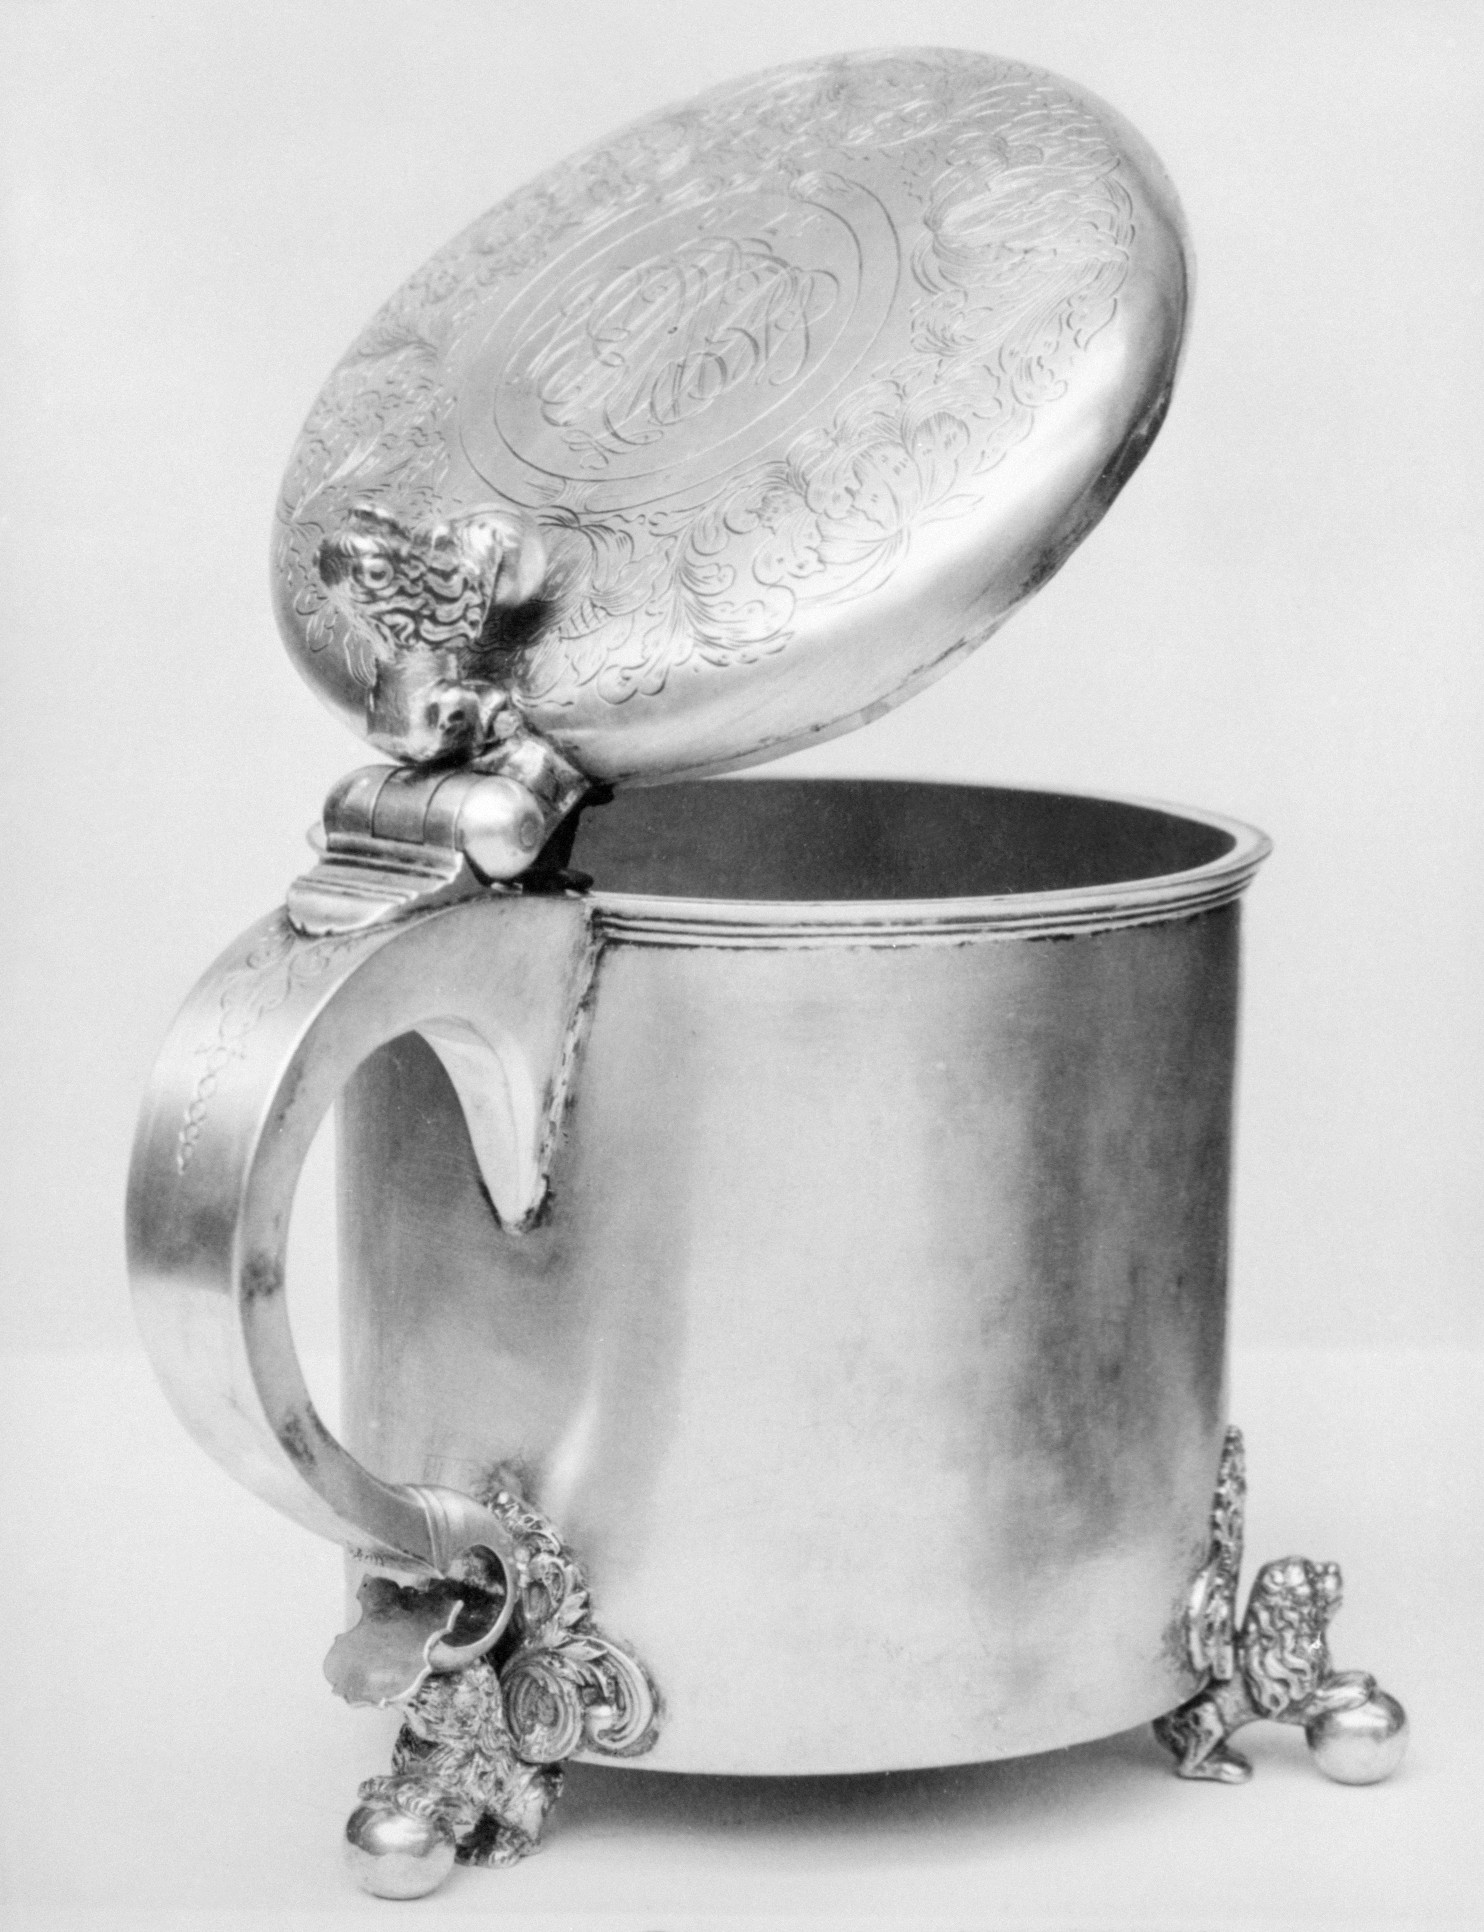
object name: peg tankard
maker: bendix aagsen lund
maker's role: maker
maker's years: 1637-1737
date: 1711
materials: silver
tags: lions